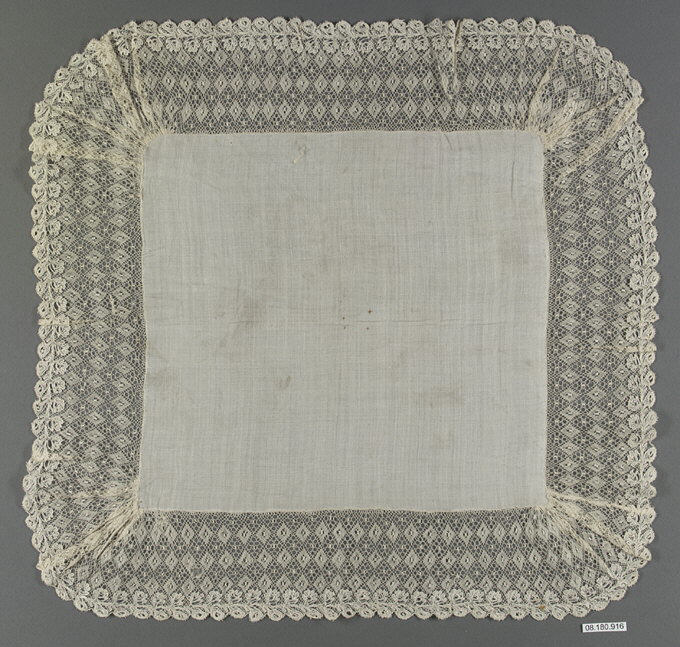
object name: handkerchief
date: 1801-1900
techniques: lace